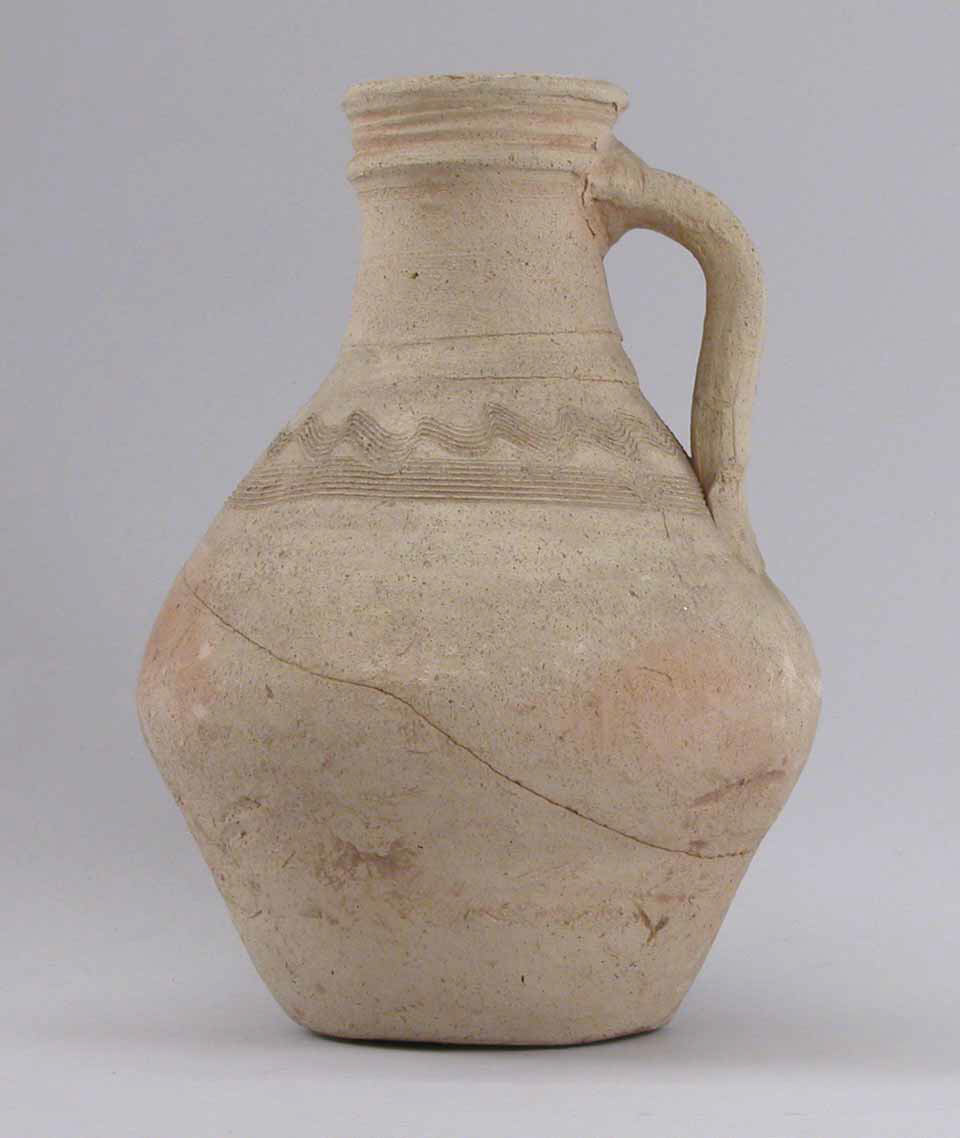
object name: ewer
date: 1001-1100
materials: earthenware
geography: iran